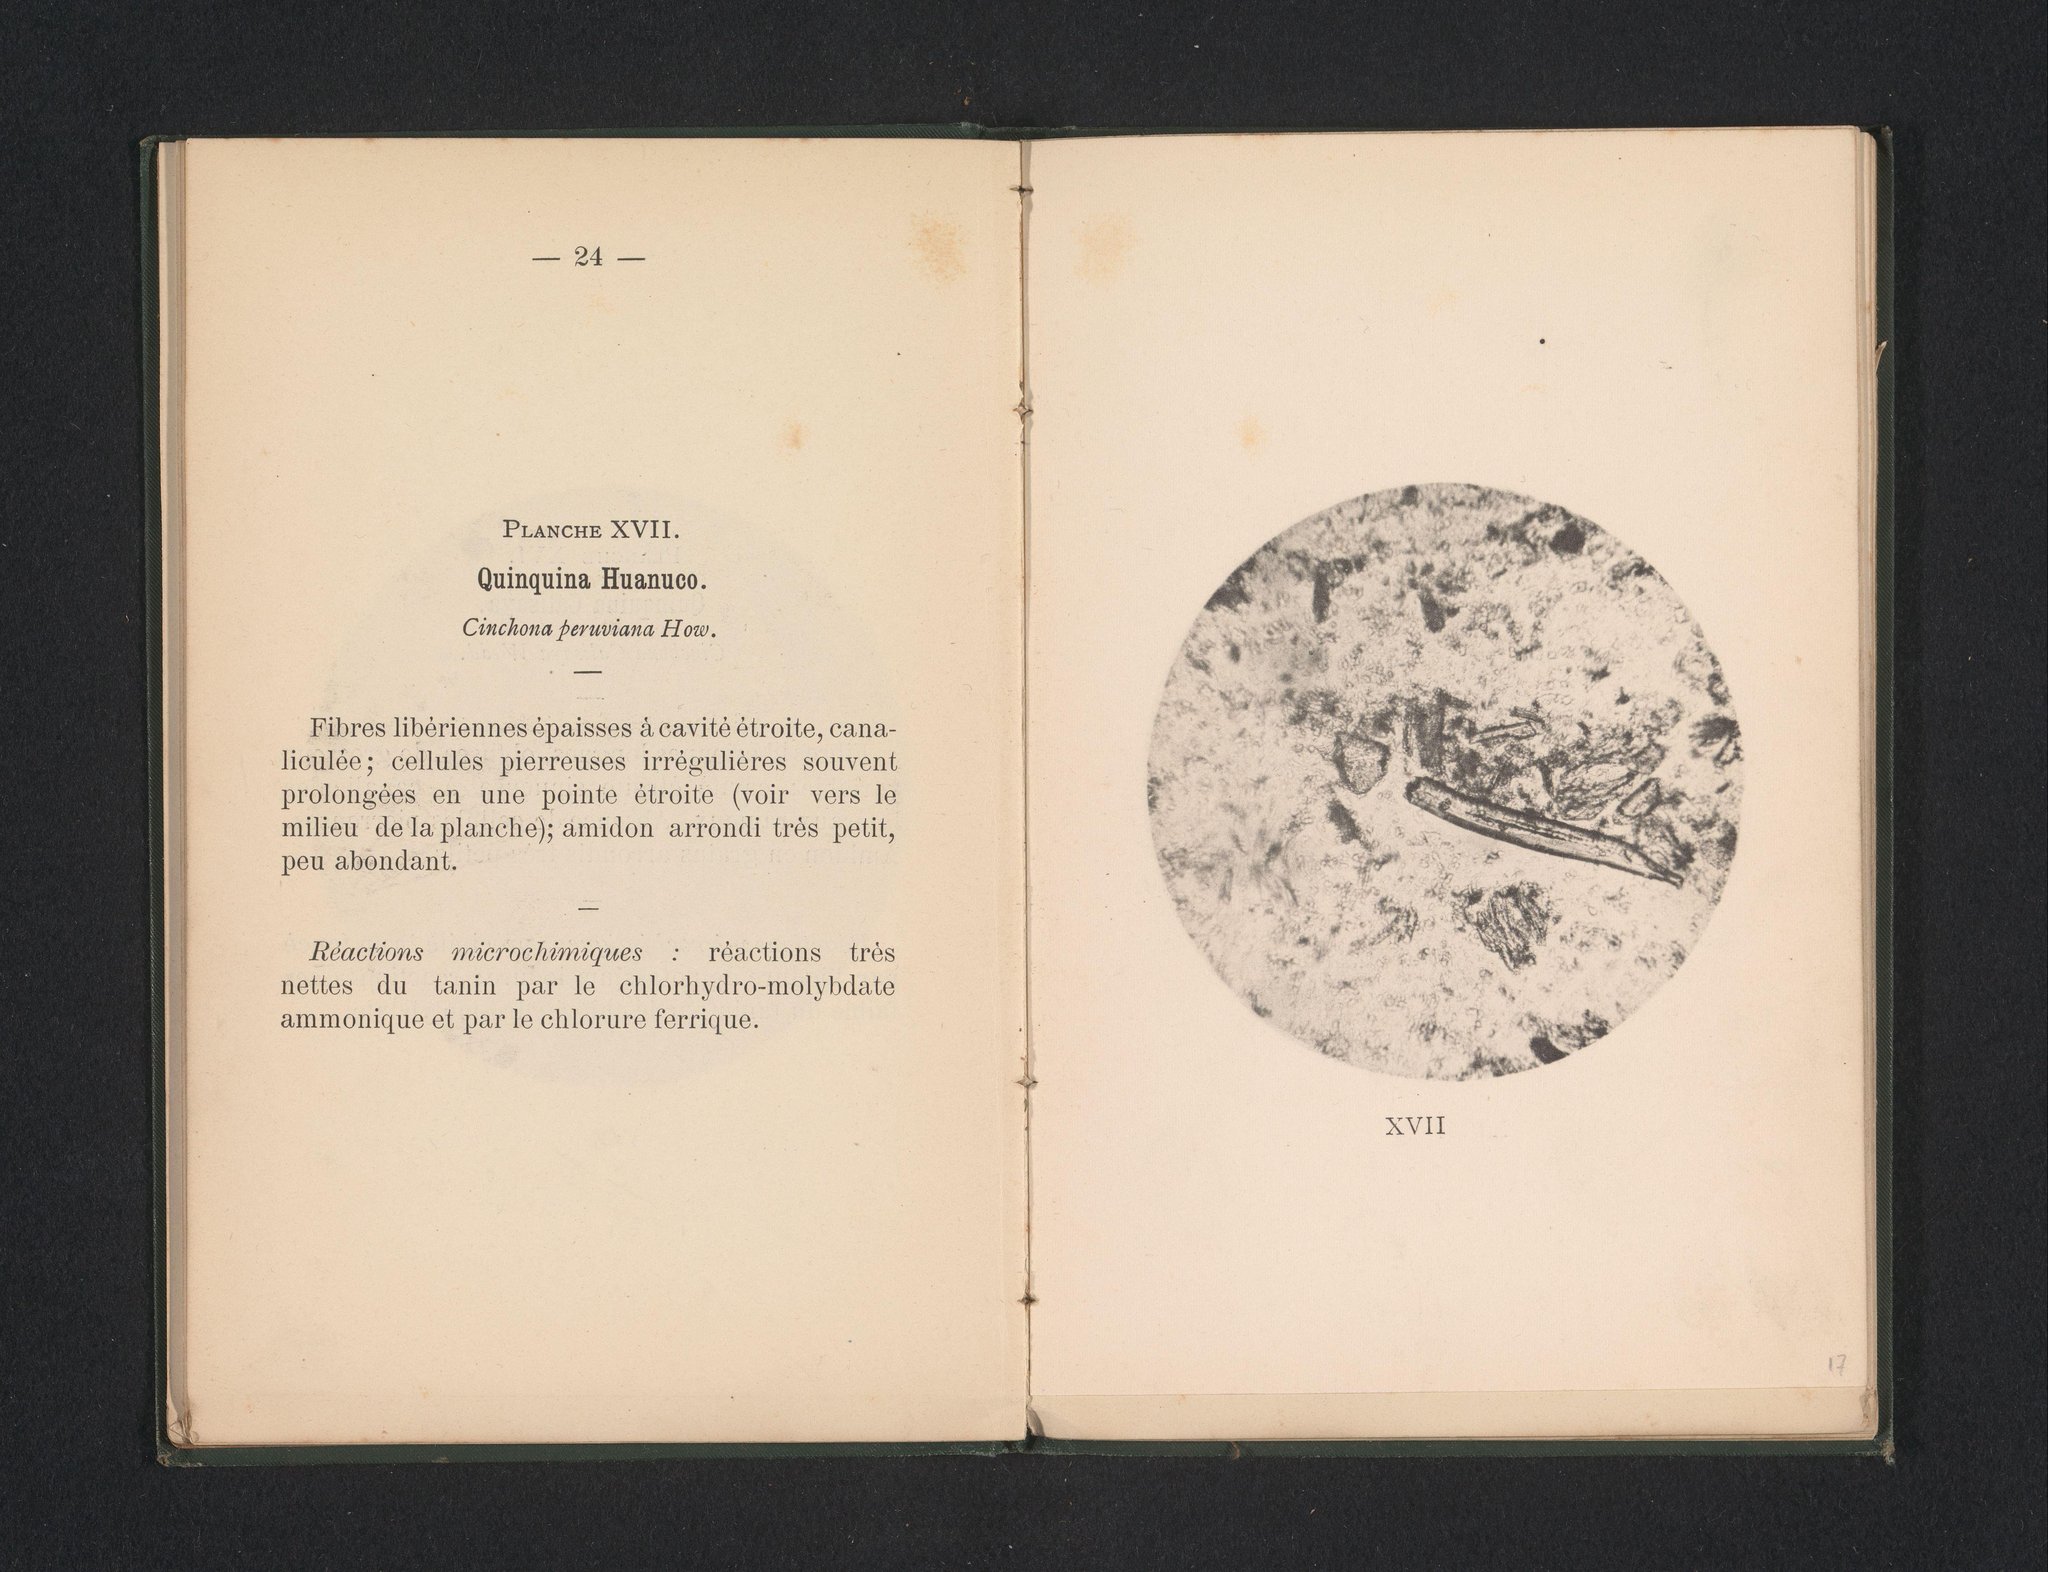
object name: page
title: Microscopische weergave van quinquina peruviana How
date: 1891-1896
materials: paper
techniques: photograph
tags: microscope (+ scientific research)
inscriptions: number: ‘XVII’